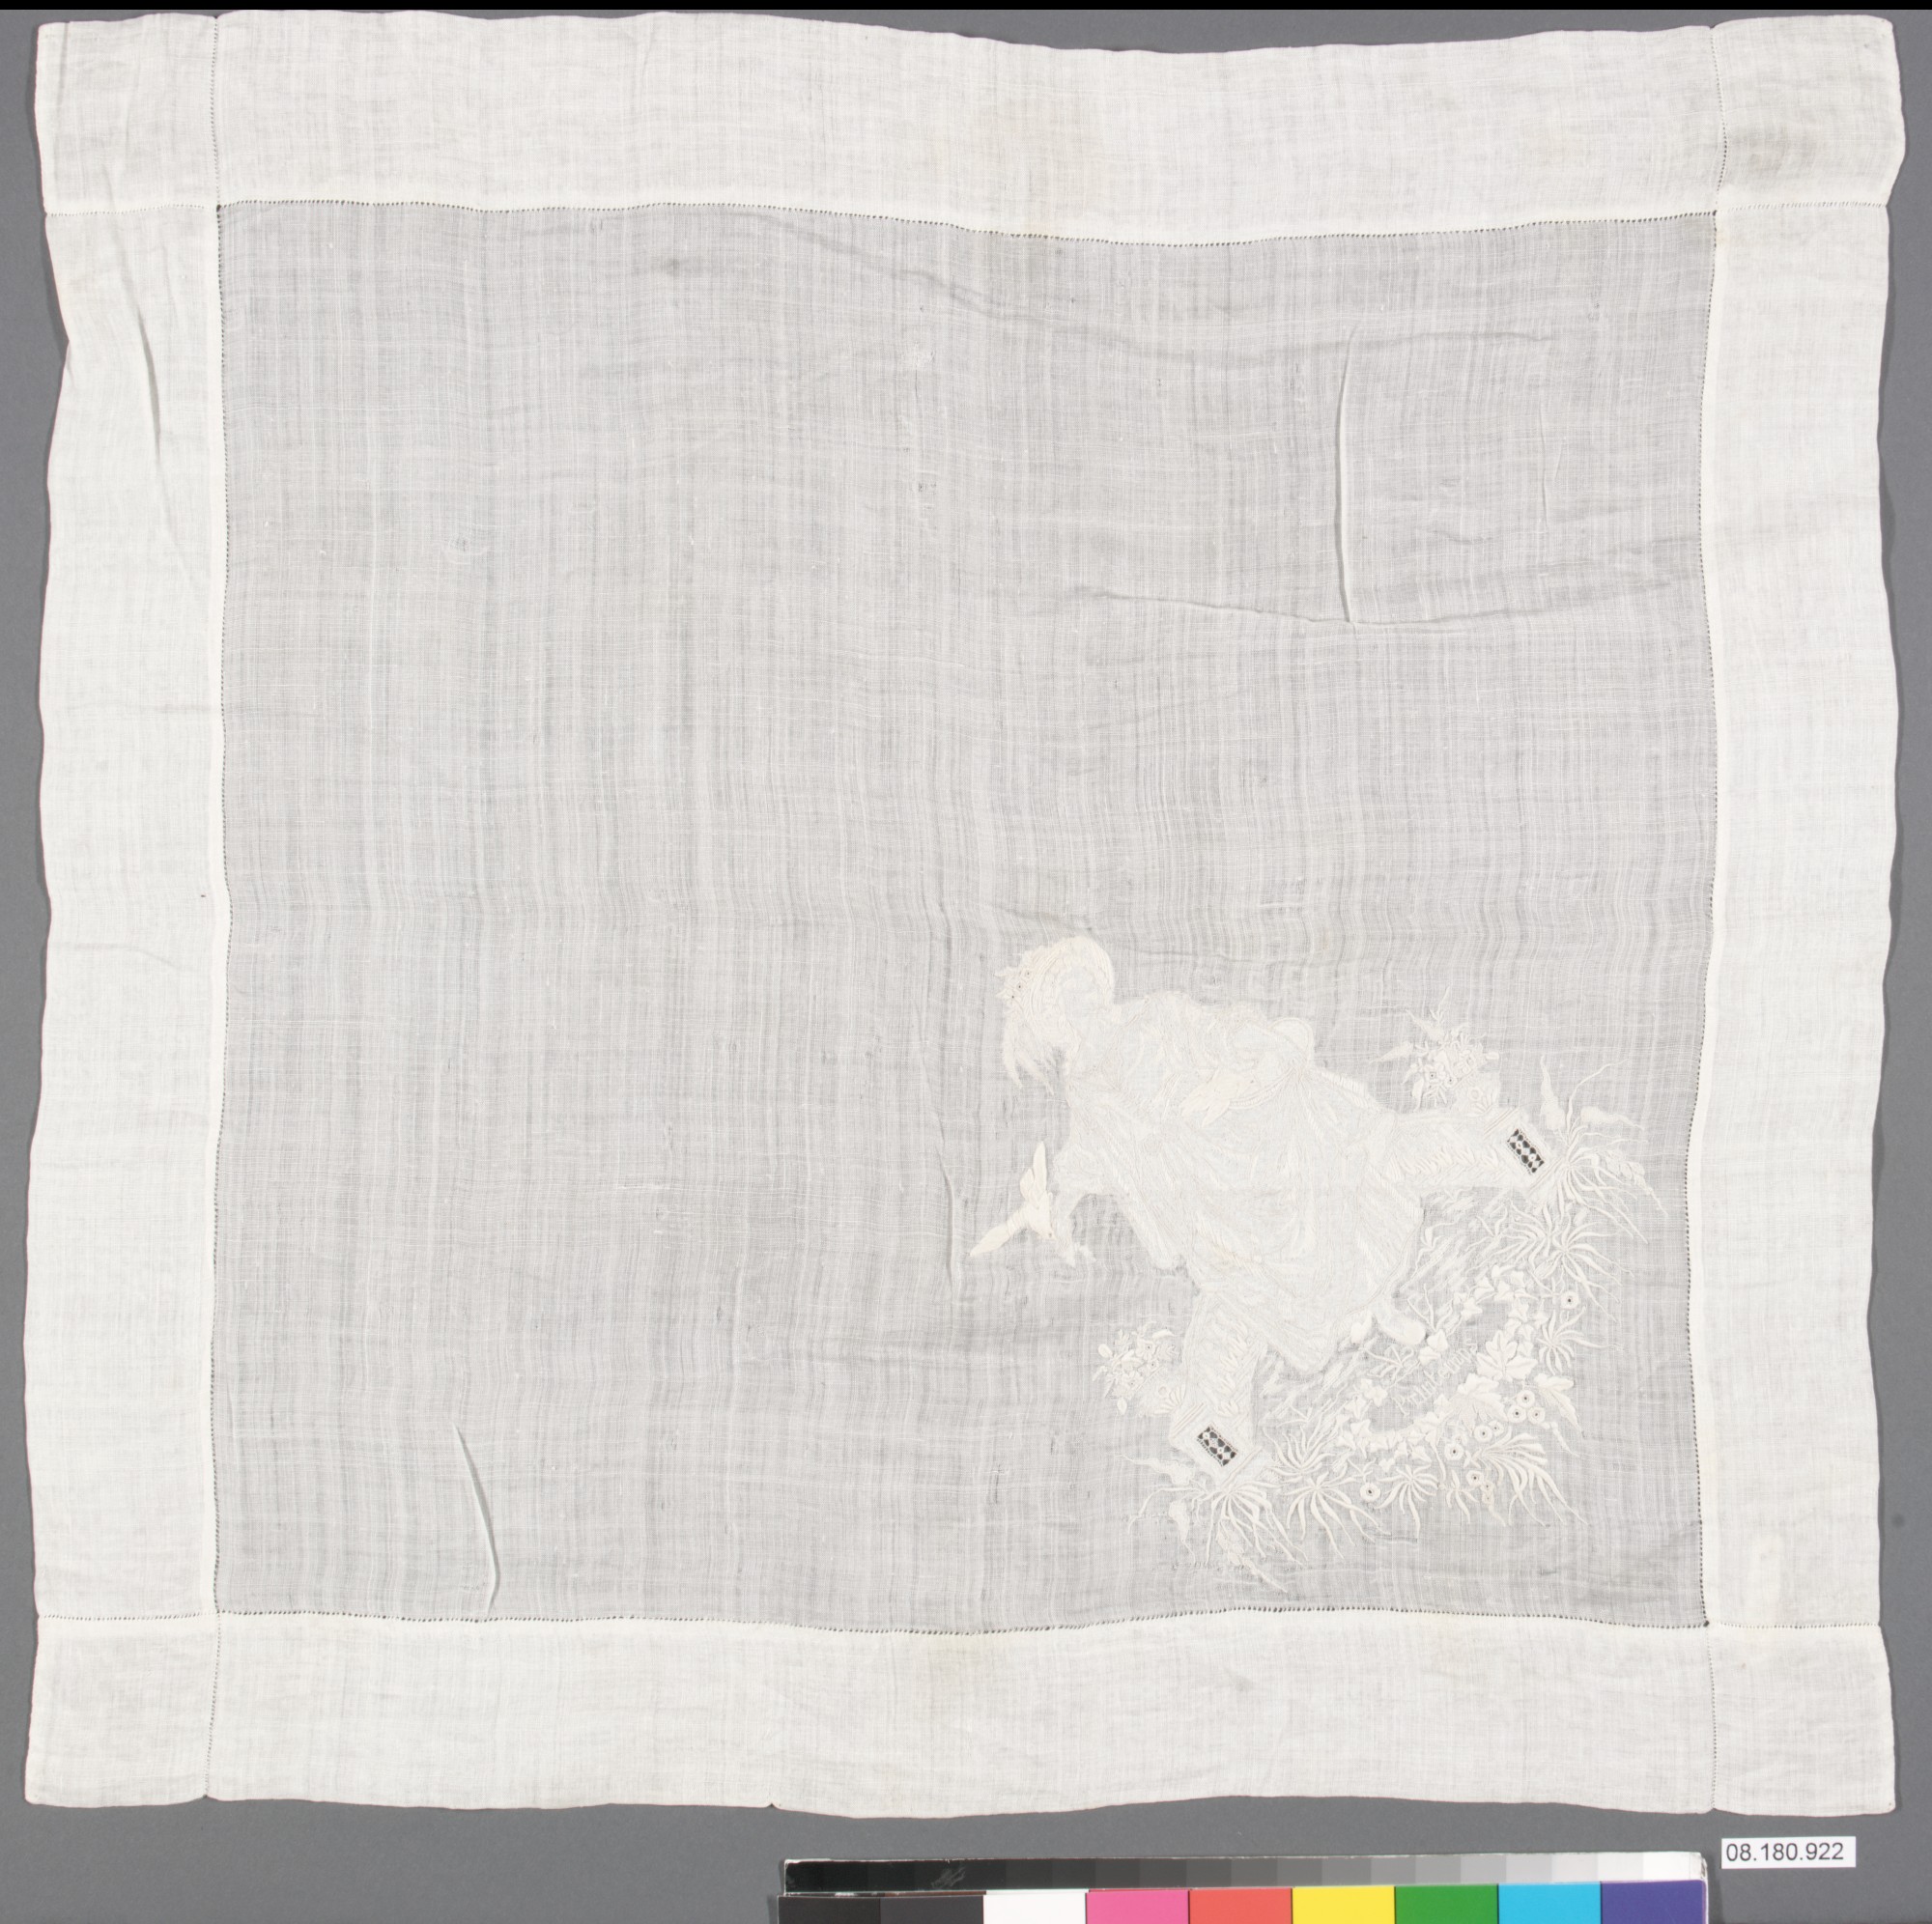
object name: handkerchief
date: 1801-1833